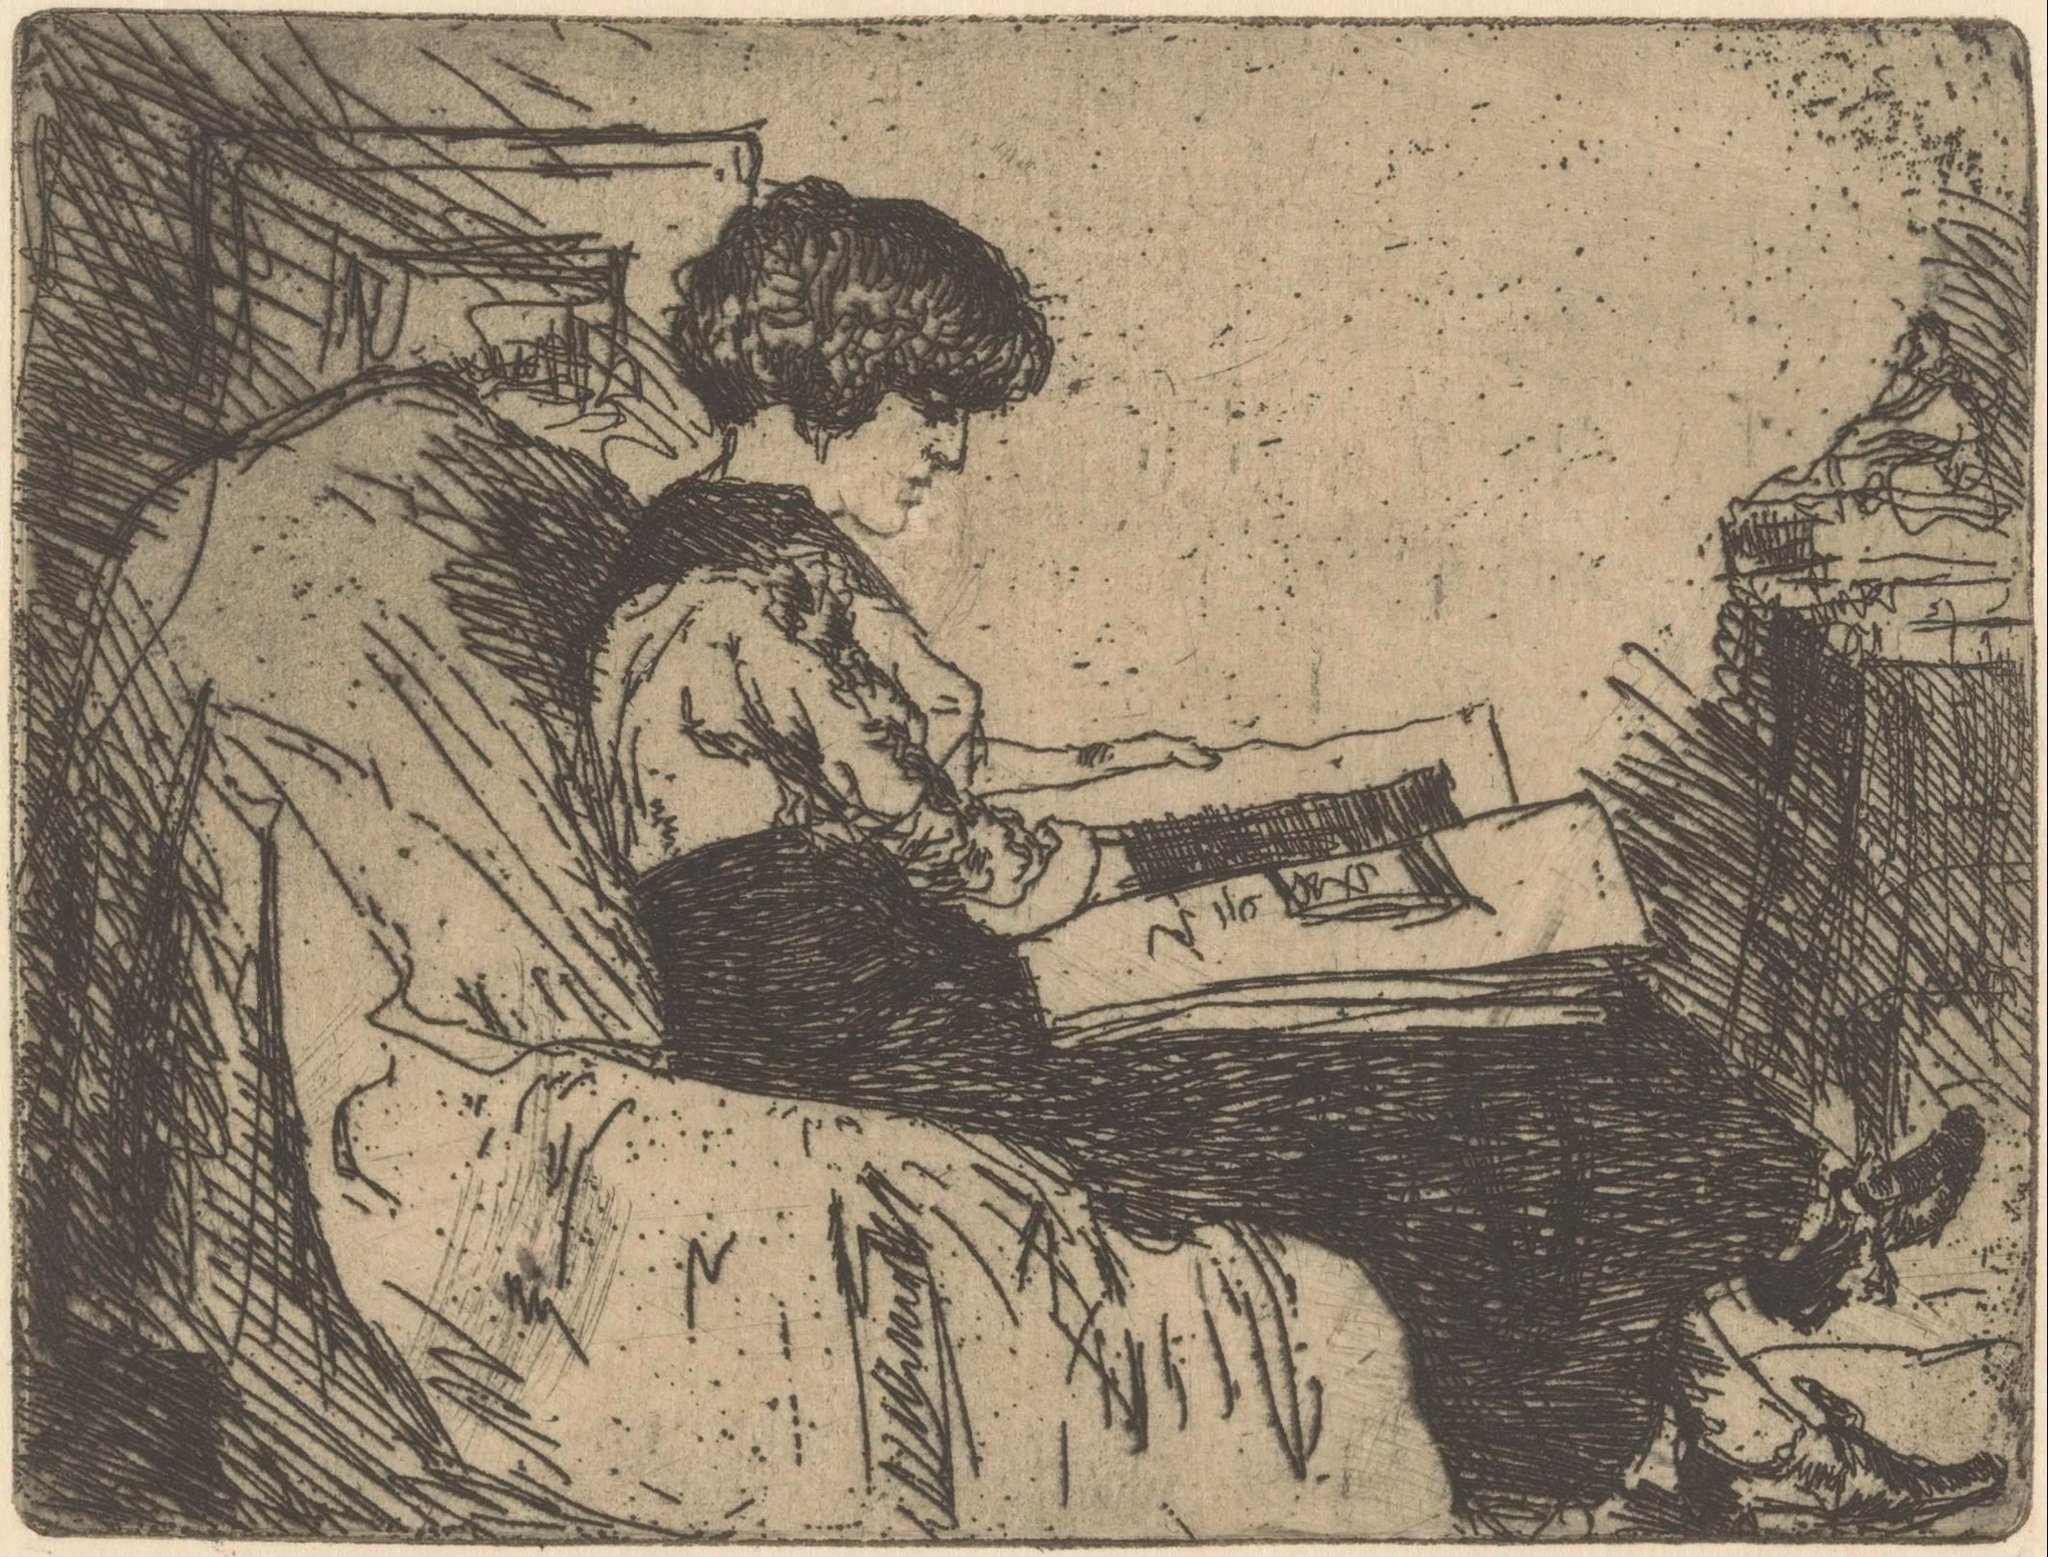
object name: print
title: Portret van Martha Grondhout-Heshusius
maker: willem adrianus grondhout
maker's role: draughtsman, painter, print maker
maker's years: 1878-1934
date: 1888-1934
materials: paper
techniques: etching, intaglio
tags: amsterdam, painter, draughtsman, reading, historical persons - bb - woman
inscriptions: collector's mark: Lugt 2228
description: Een portret van kunstenaar Martha Grondhout-Heshusius, echtgenote van Willem Adrianus Grondhout, die lezend in een stoel zit.